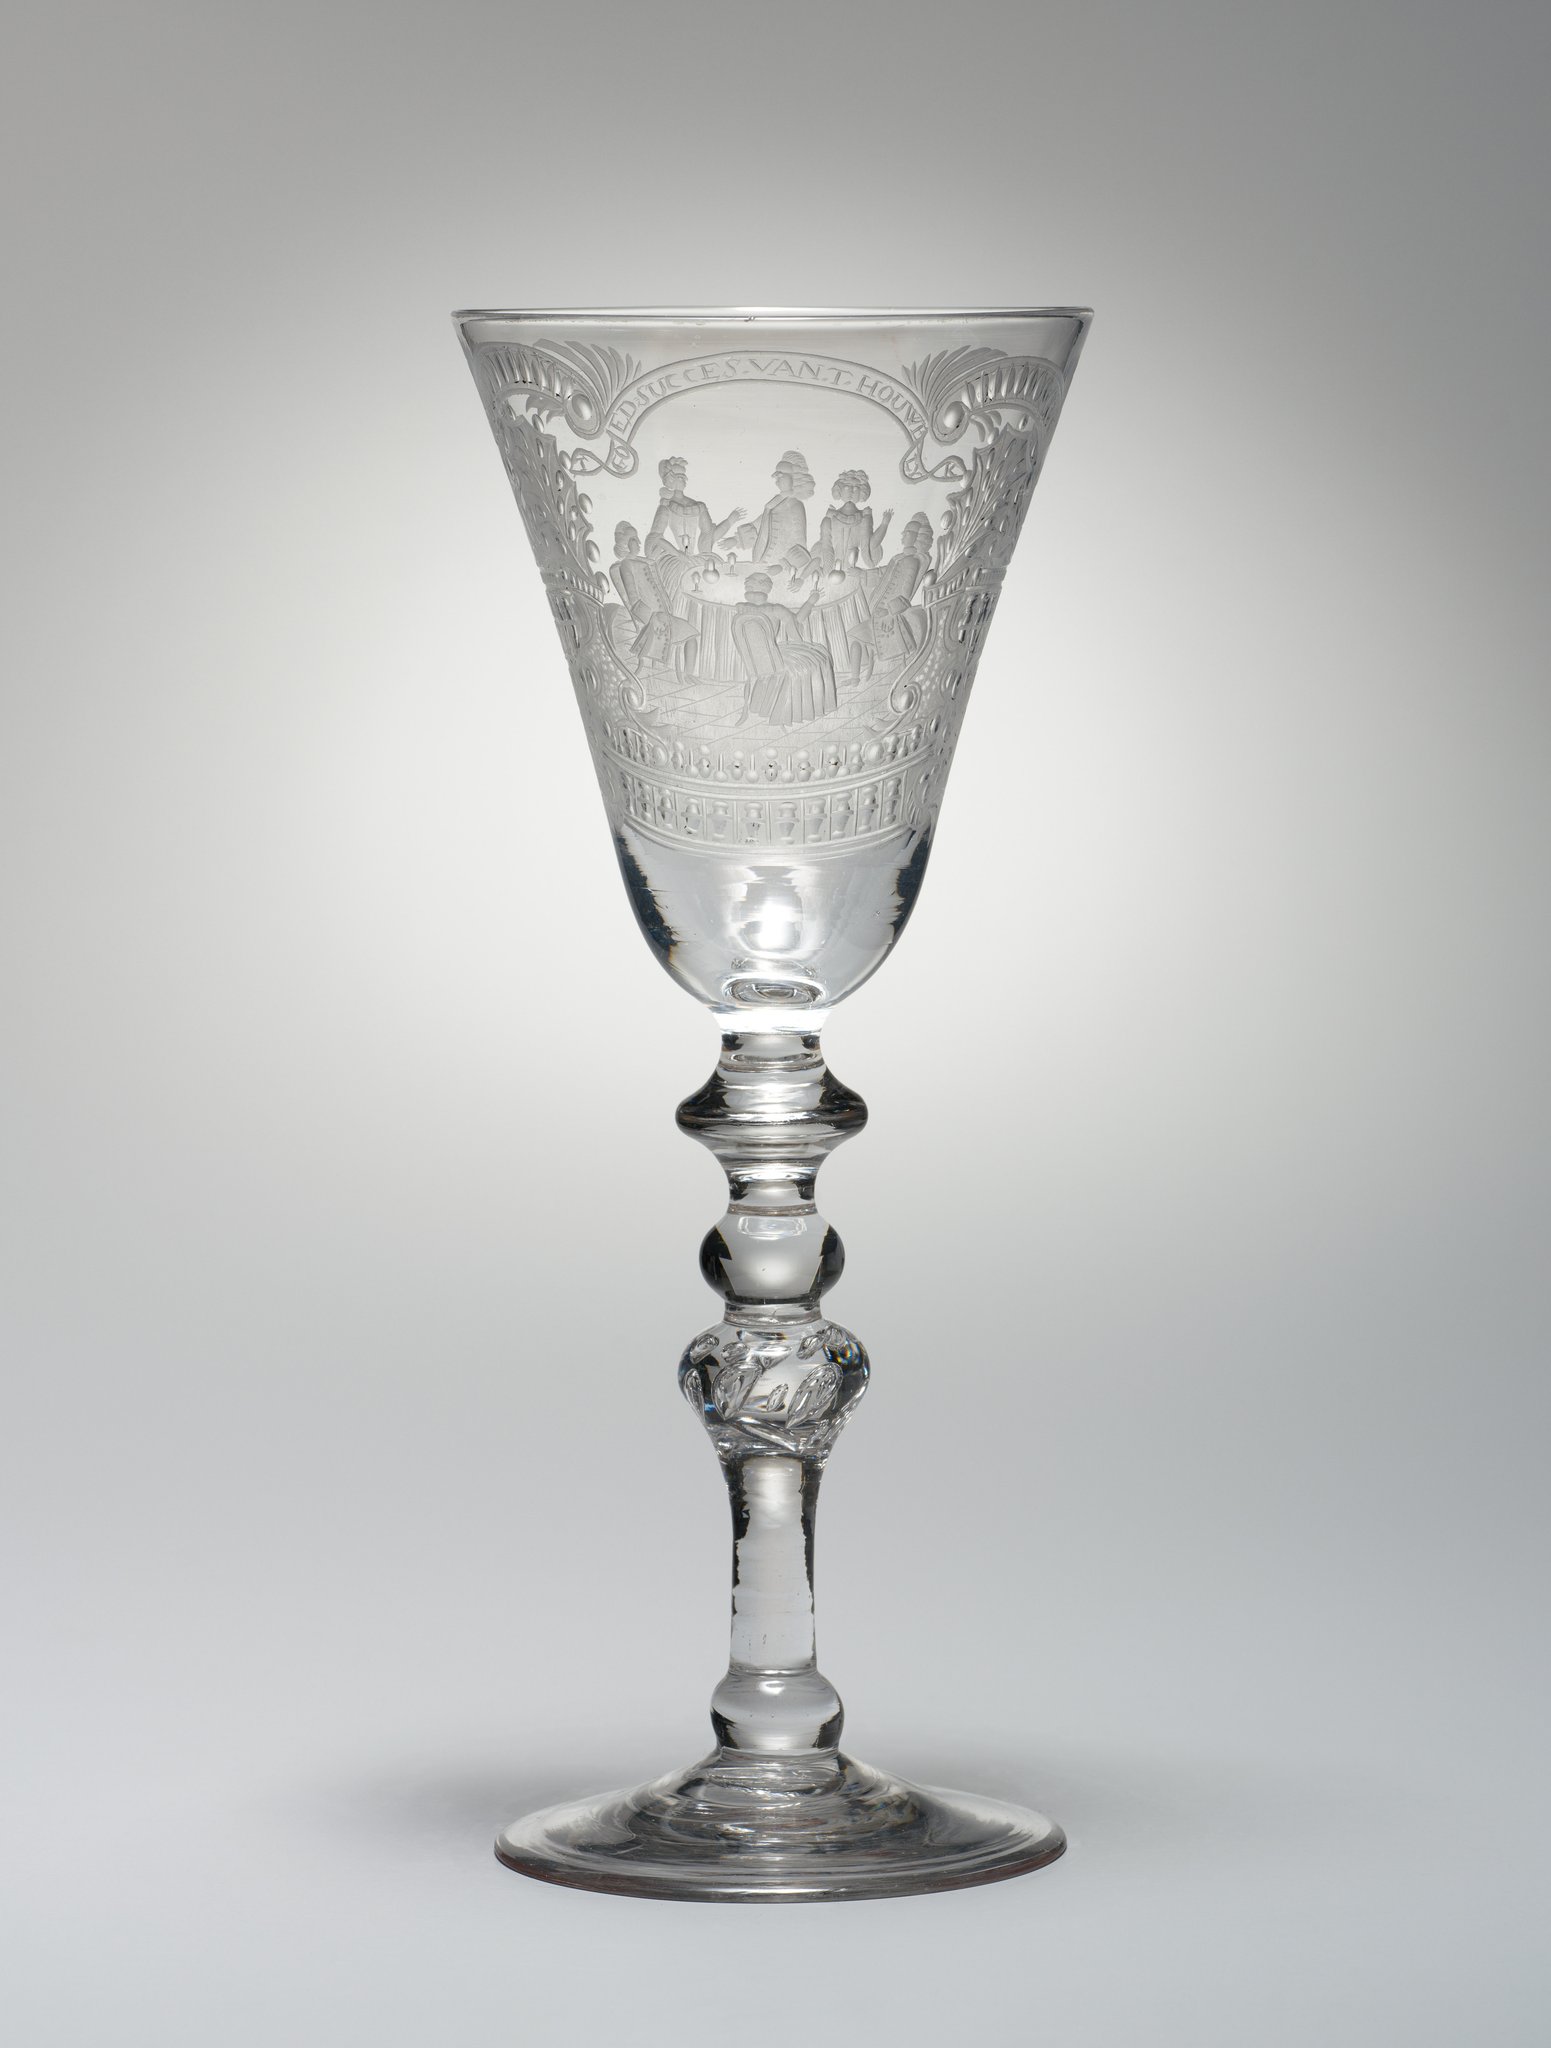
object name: wineglass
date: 1750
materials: glass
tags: men,women